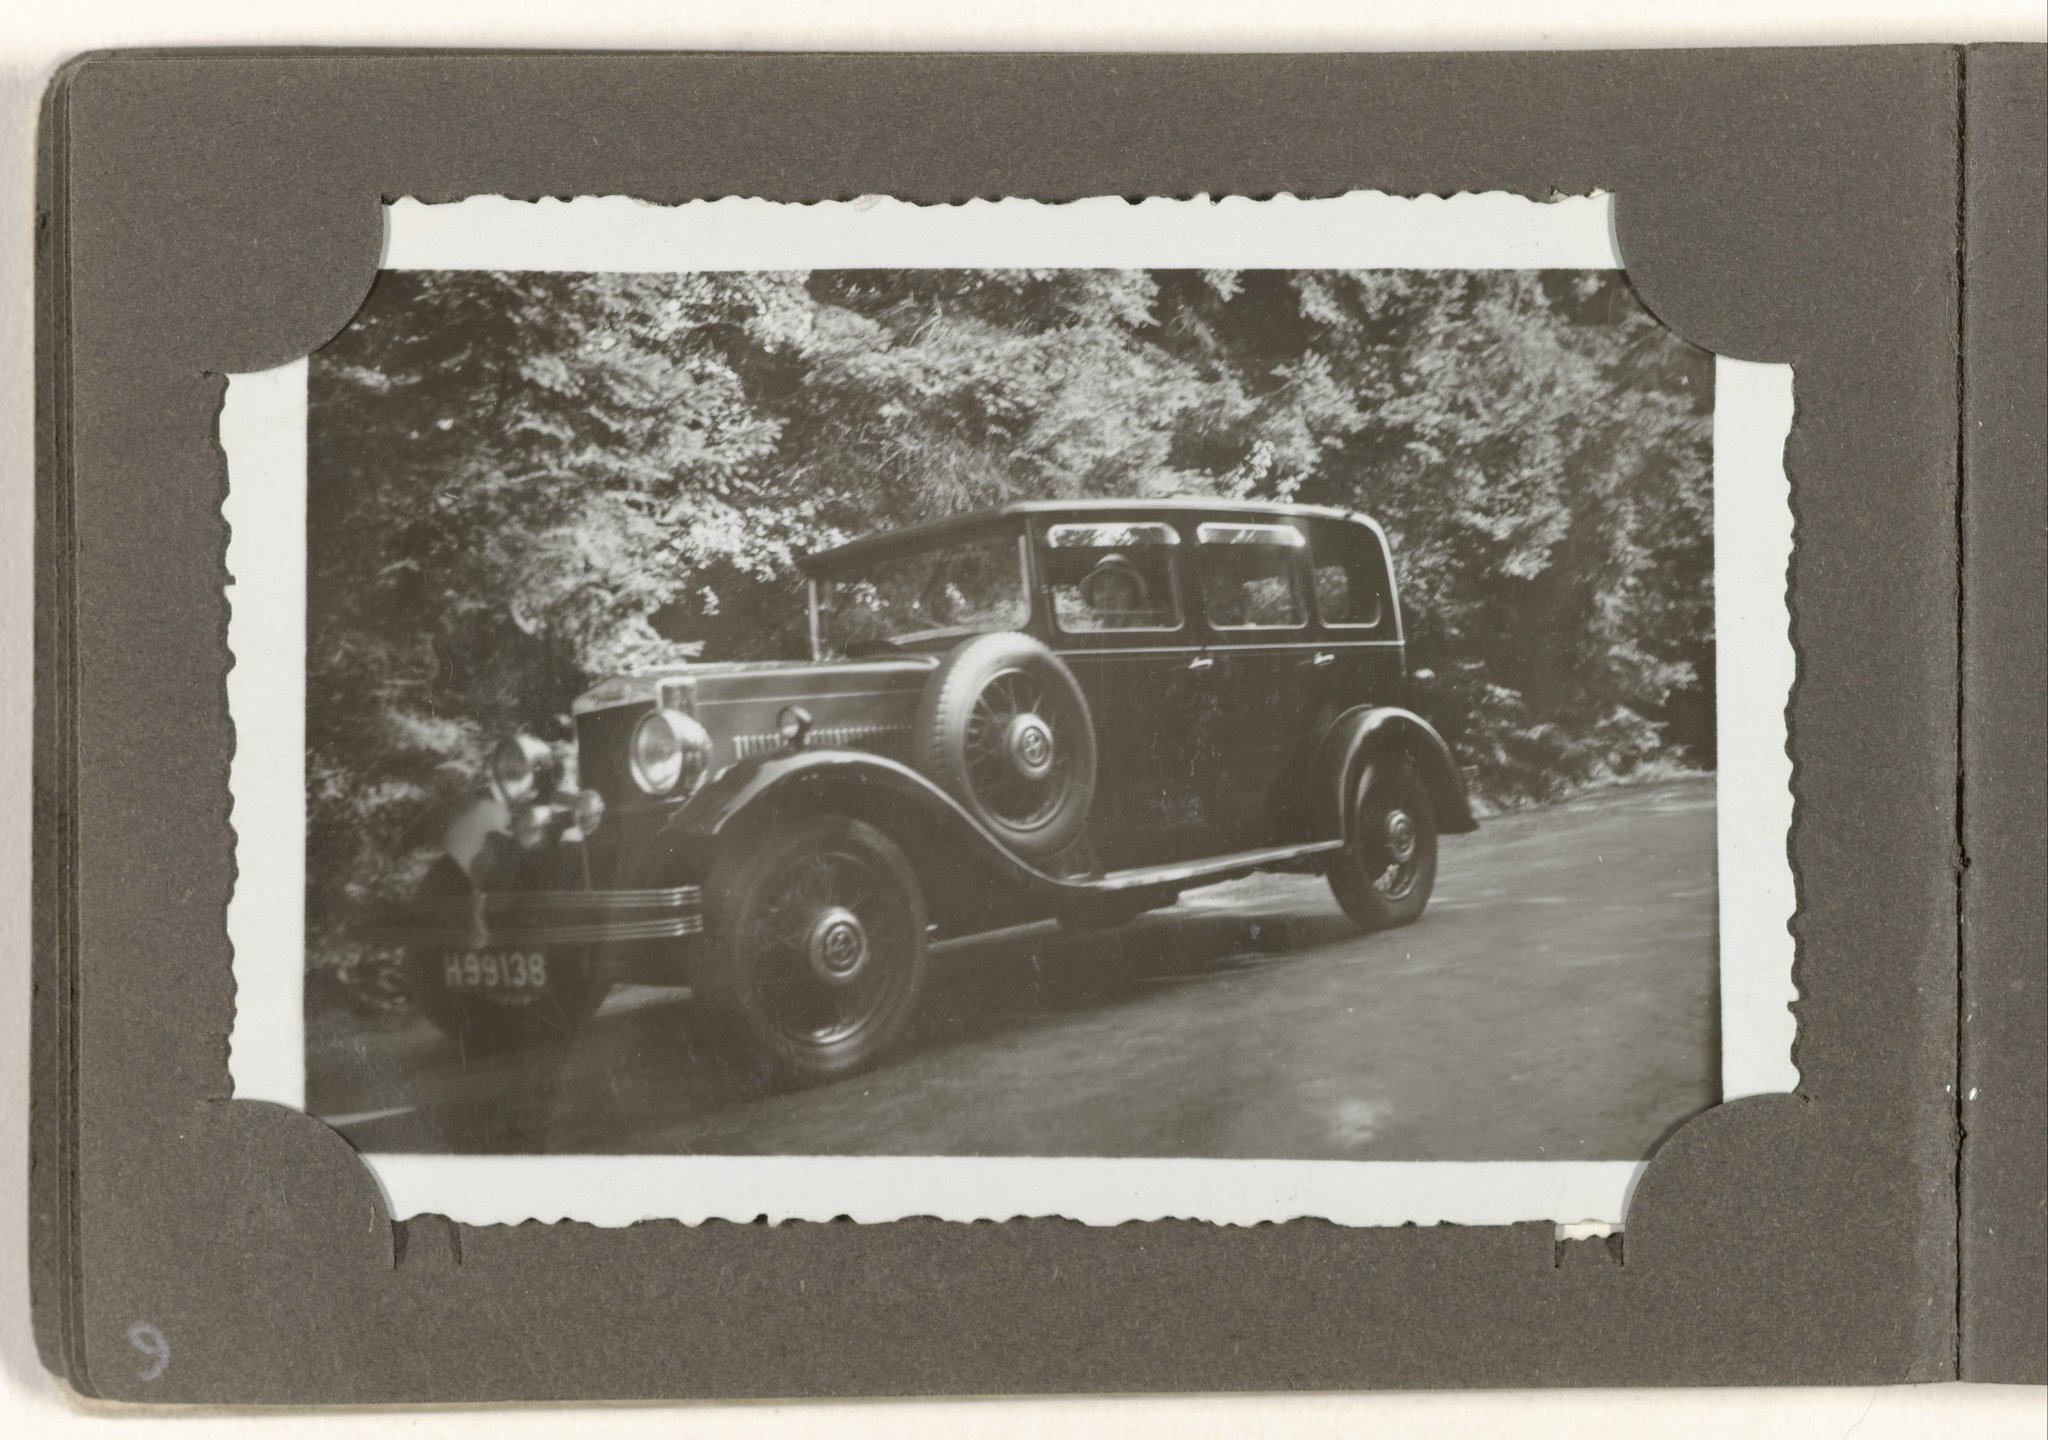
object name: photograph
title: Auto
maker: Anonymous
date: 1933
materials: photographic support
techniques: gelatin silver print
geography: rotterdam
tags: wim van den bosch, rotterdam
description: Auto op een weg, met een vrouw aan het stuur. Onderdeel van het familiealbum 1933-1944.